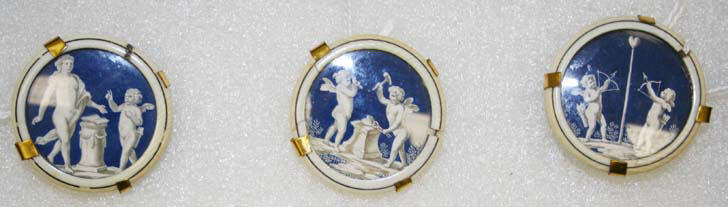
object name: button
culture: european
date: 1780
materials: glass, ivory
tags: female nudes,cupid